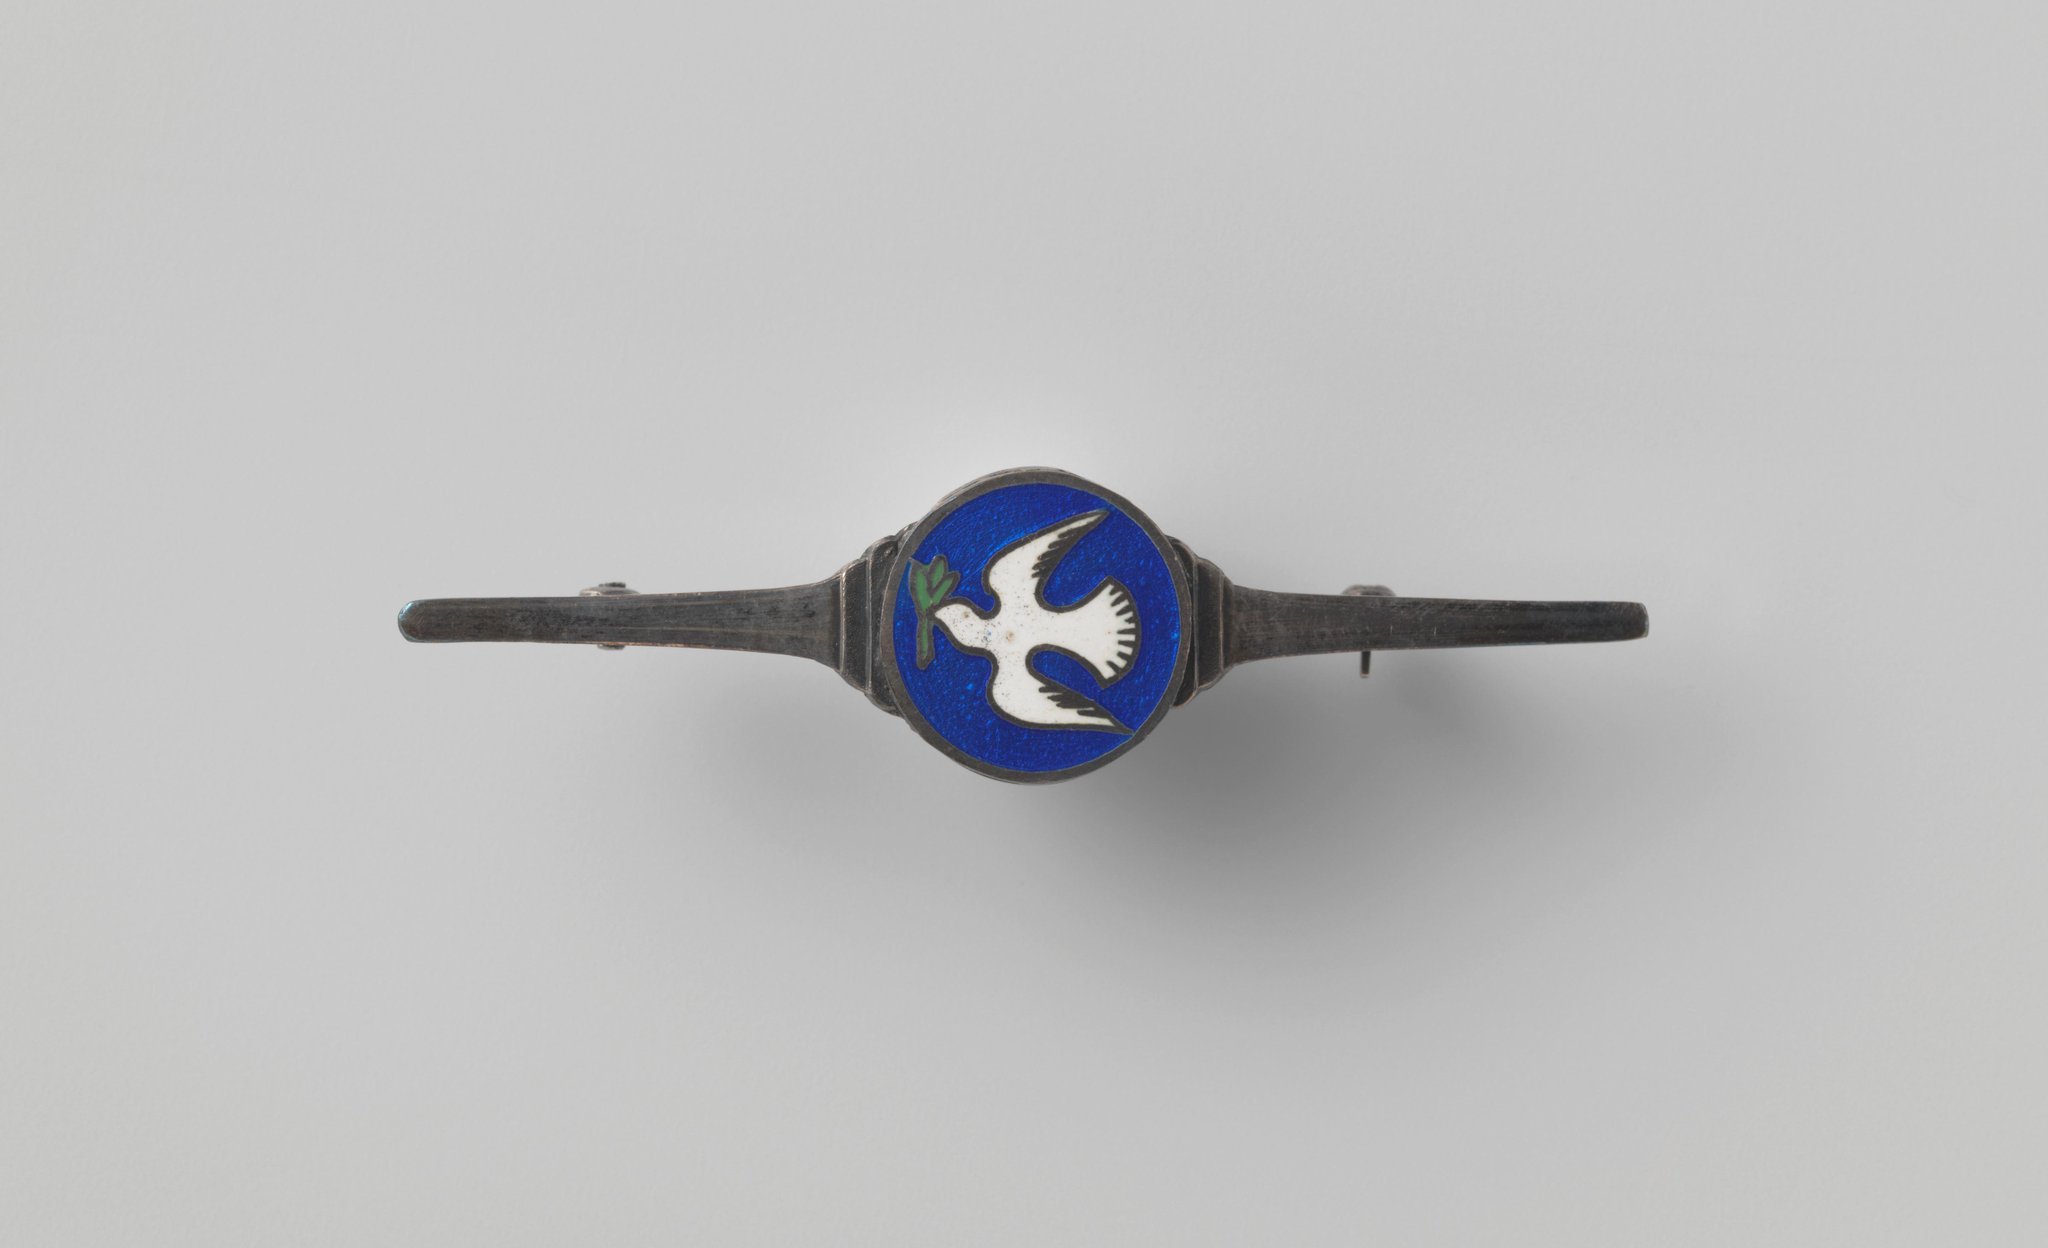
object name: brooch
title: Miscellaneous brooches and coin jewels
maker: Anonymous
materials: metal, silver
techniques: enameling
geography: netherlands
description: Silent Resistance –War and Liberation Jewellery During the Second World War, small pieces of jewellery were worn in the Netherlands as a silent protest against the German occupier. In April 1941, Dutch coins were officially confiscated for the war industry. As jewellery did not have to be surrendered, coins were quickly transformed into rings, brooches, pins and bracelets. A portrait of Queen Wilhelmina was worn as a sign of resistance, as well as a token of loyalty to the royal family. Margriet Francisca, the third daughter of Princess Juliana and Prince Bernard, was born in Canada in January 1943. The pin with the three yellow chicks refers to the three young princesses Beatrix, Irene and Margriet and the steadfastness of the Dutch royal family. After the liberation, coins and silver were used for jewellery conveying messages of hope for a peaceful future.